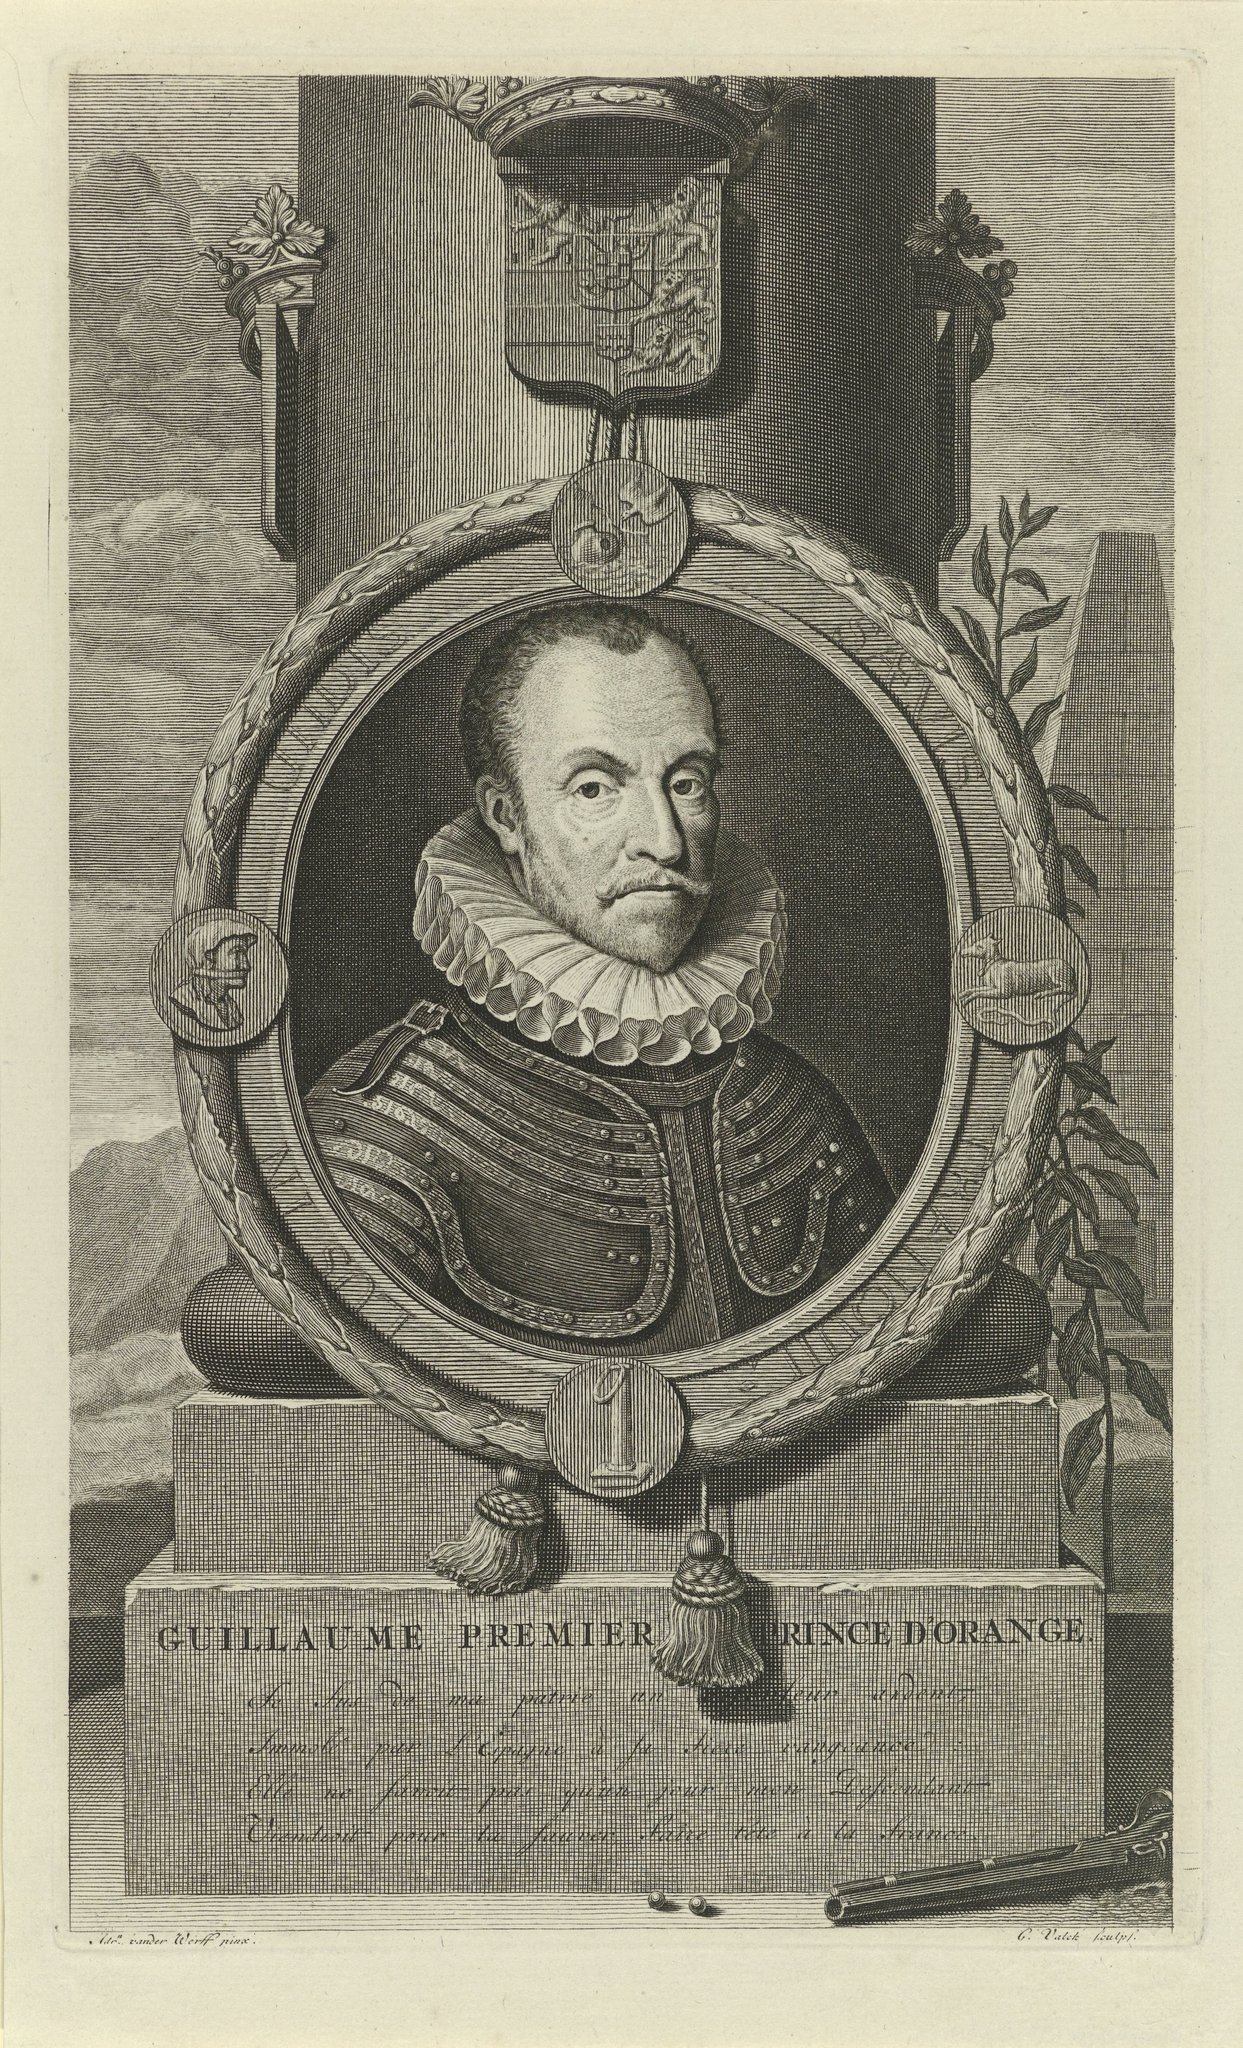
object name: print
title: Portret van Willem I, prins van Oranje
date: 1697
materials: paper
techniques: engraving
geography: rotterdam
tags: delft, william i (prince of orange)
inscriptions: collector's mark: Lugt 963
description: De hier vermelde titel verwijst naar de hoogst verkregen titel van de geportretteerde, niet per se naar de titel die de geportretteerde op deze voorstelling draagt. Prent uit: Larrey, Isaac de. Histoire d'Angleterre, d'Ecosse, et d'Irlande. Rotterdam: Reinier Leers, 1697.